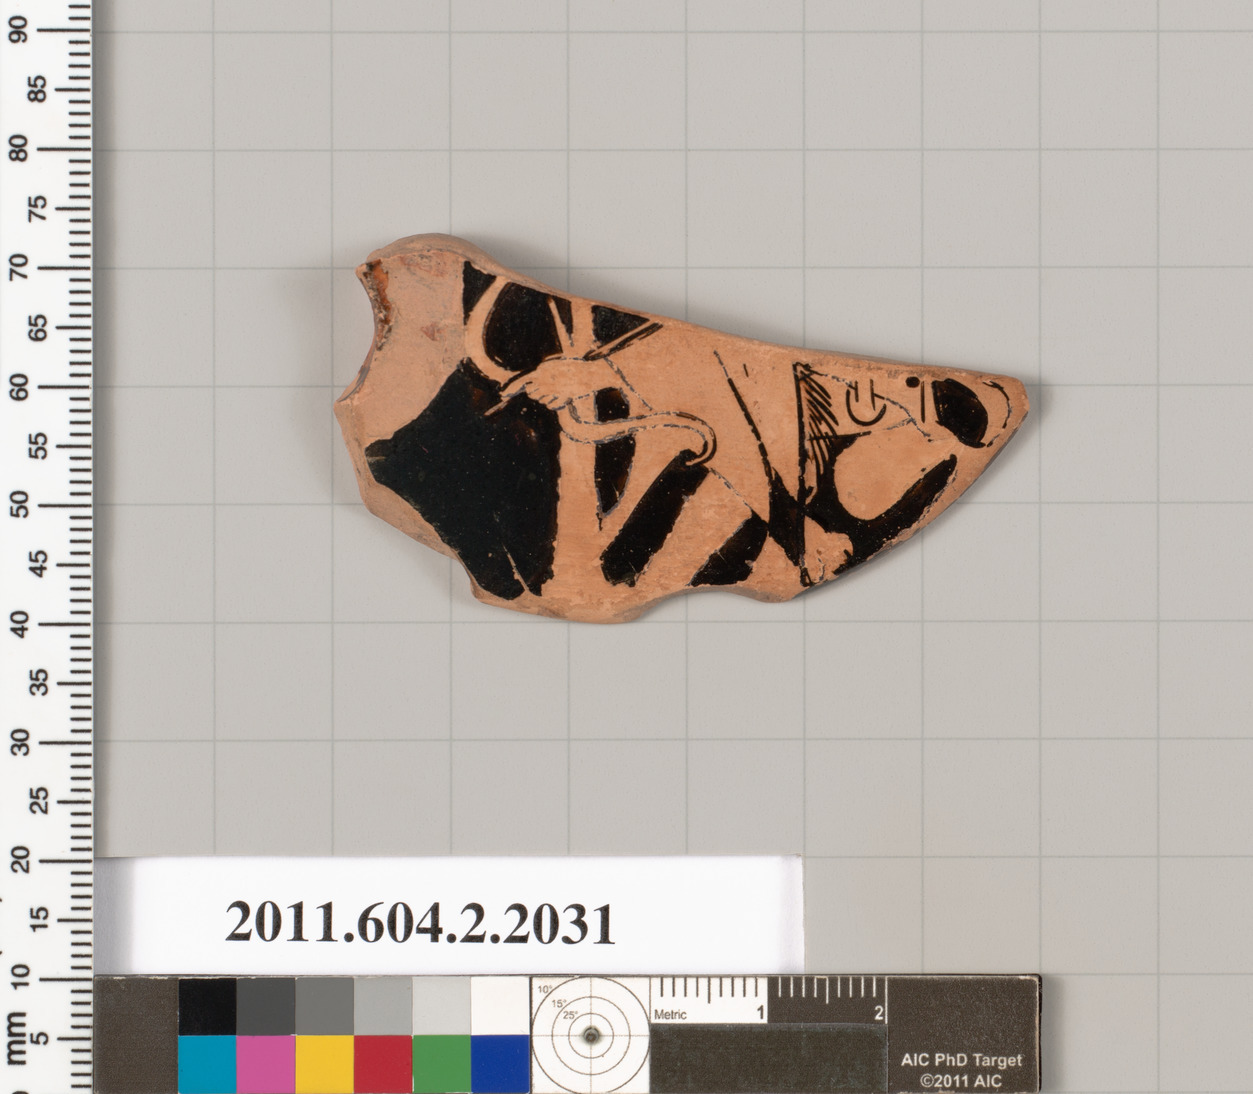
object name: strainer fragment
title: Terracotta fragment from a strainer?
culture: greek, attic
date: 480-470 BCE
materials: terracotta